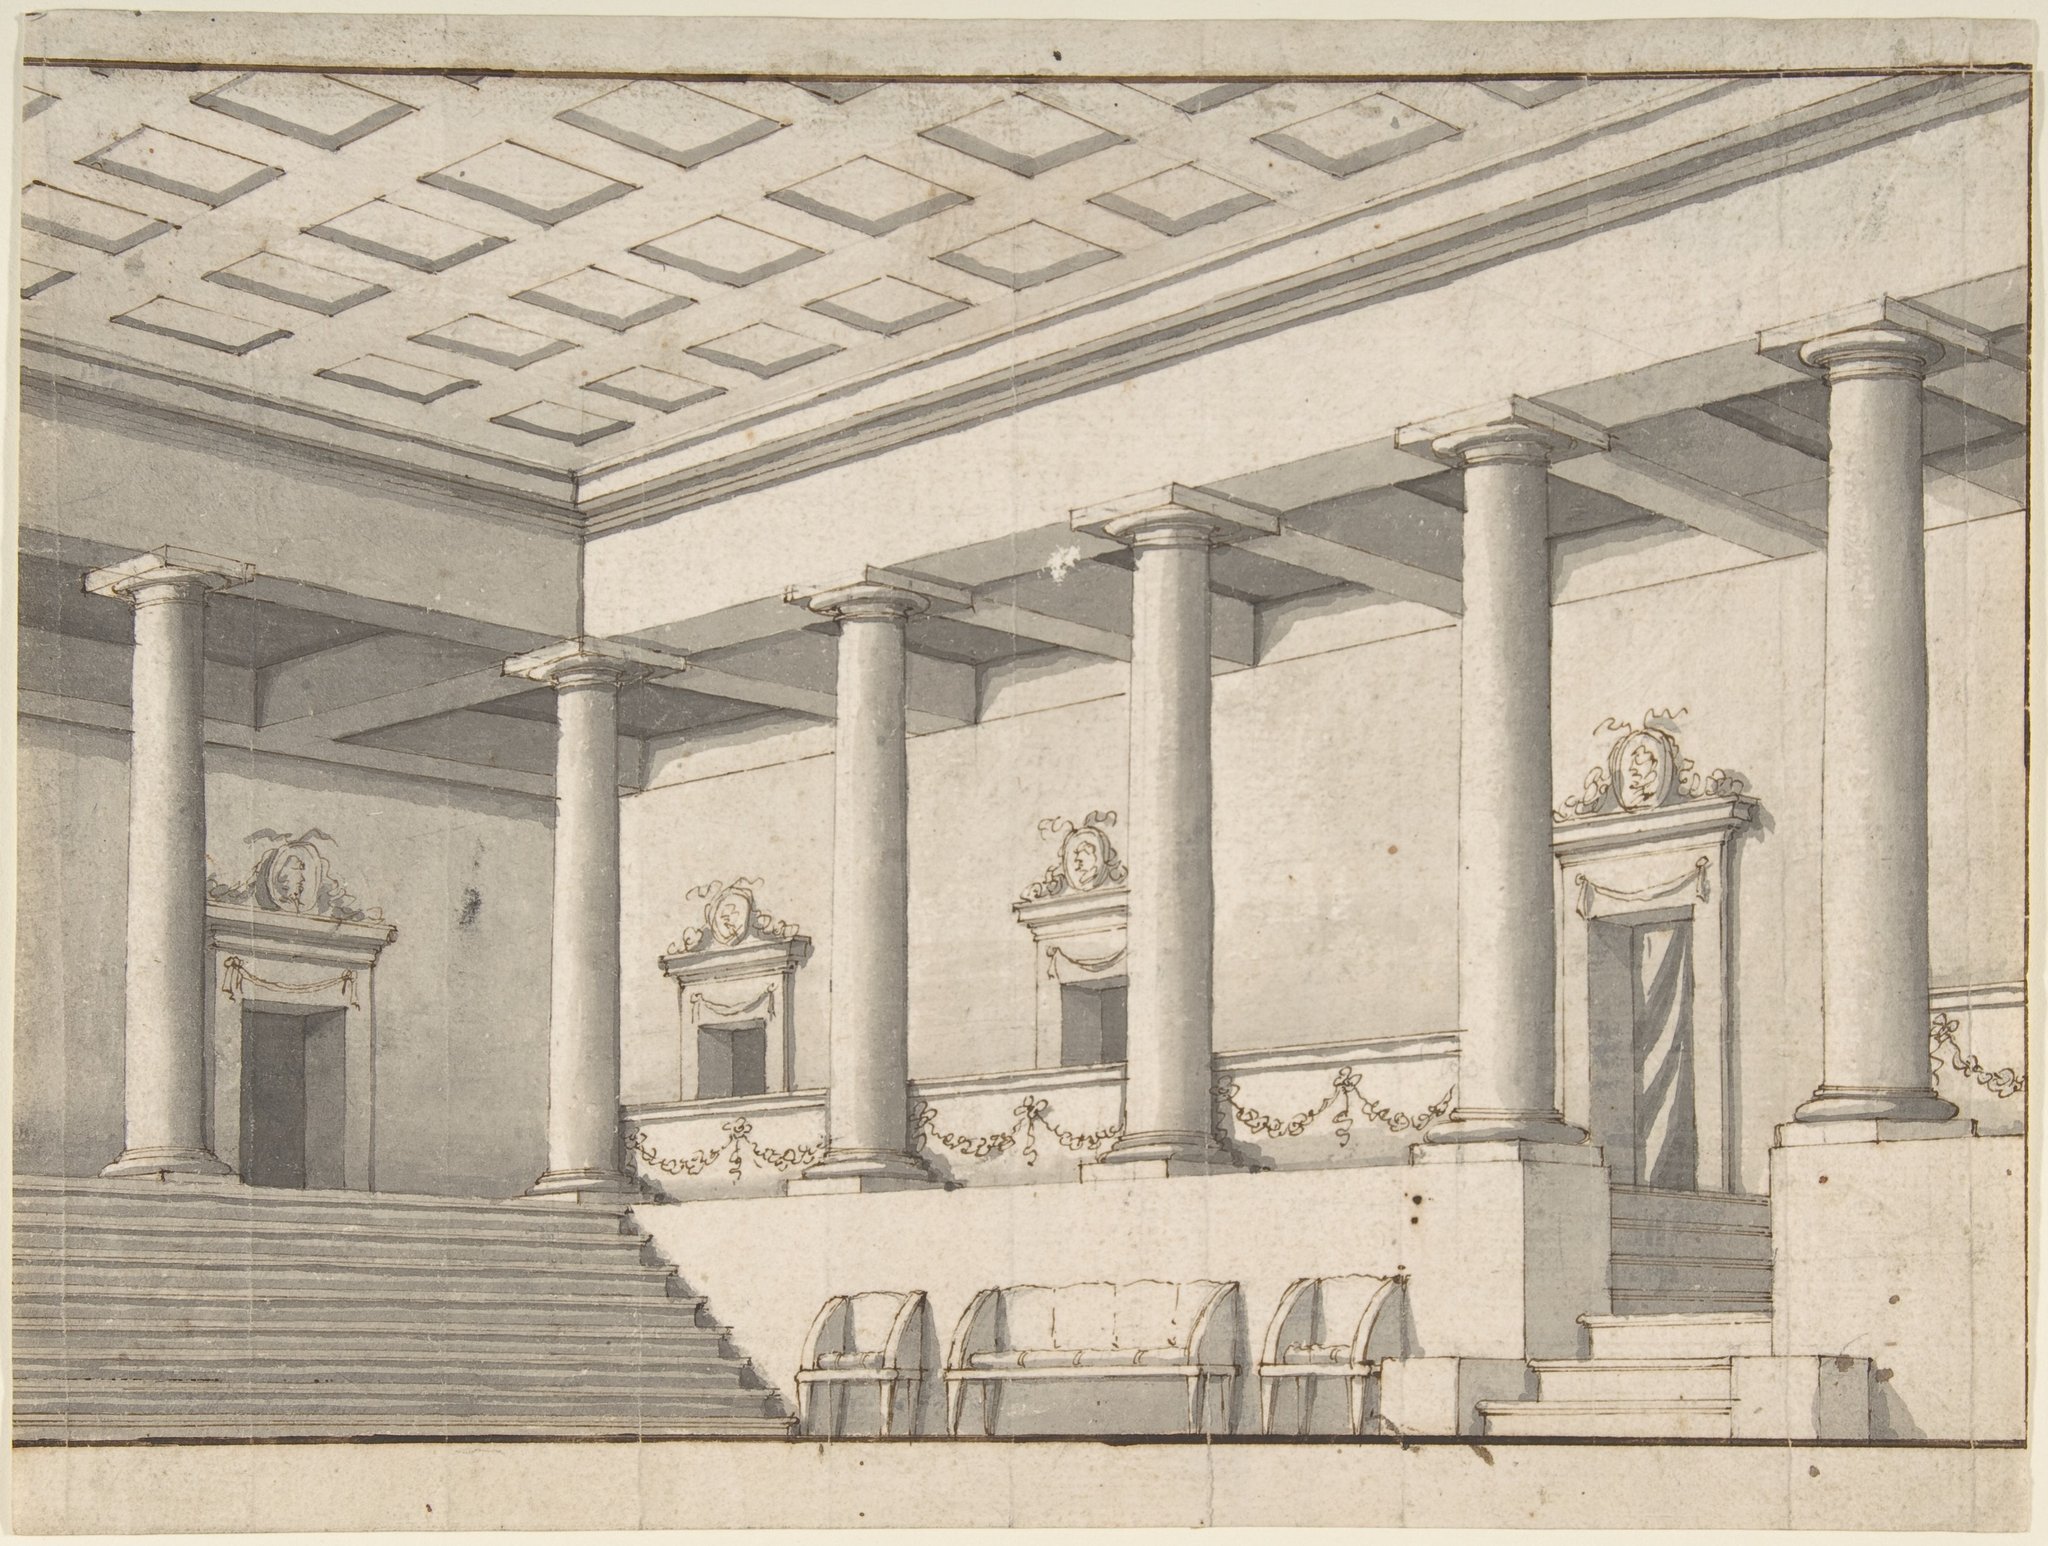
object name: drawing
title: Palace or Villa Interior, Colonnaded Hall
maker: anonymous, italian, 18th century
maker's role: artist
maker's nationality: italian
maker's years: 1700-1800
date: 1700-1750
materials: chalk, ink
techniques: pen, wash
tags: columns,stairs,interiors